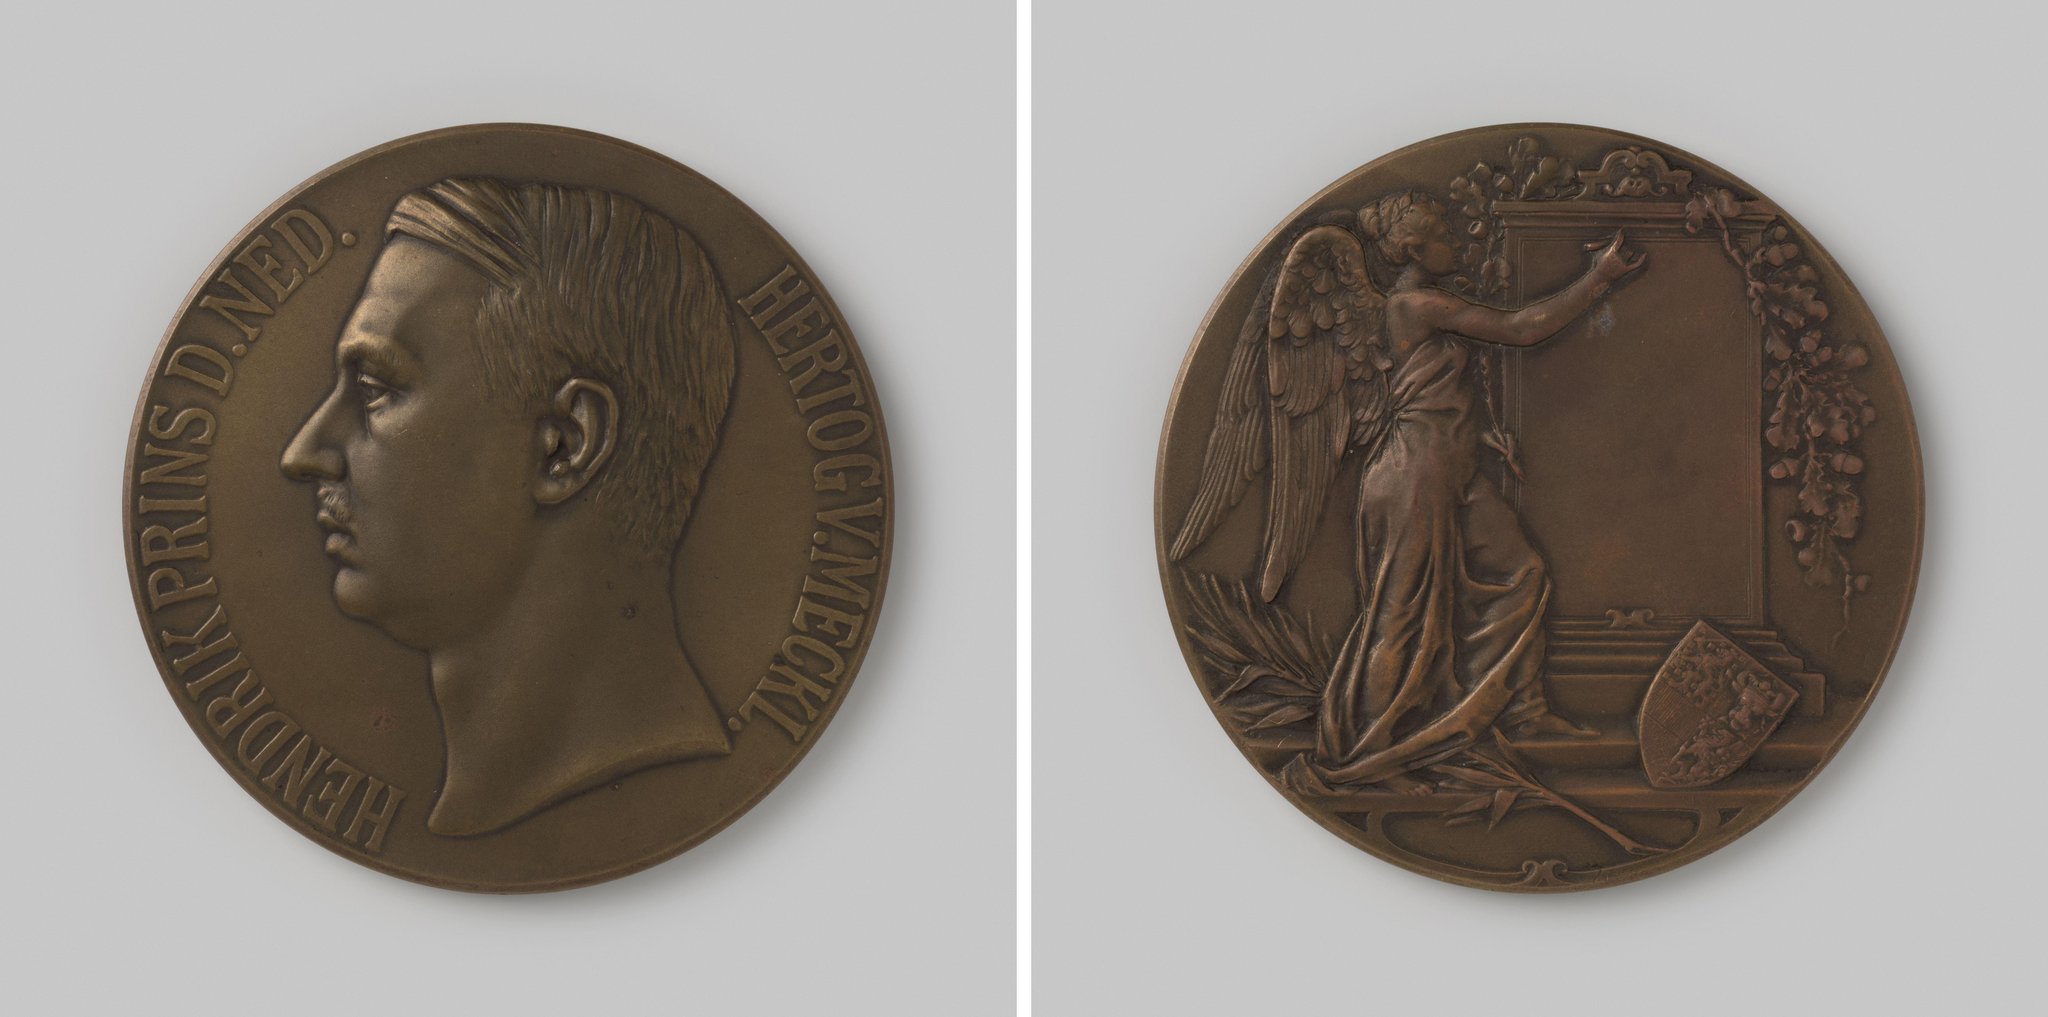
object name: medal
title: Prijspenning van Prins Hendrik der Nederlanden 1902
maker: wilhelm achtenhagen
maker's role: medailleur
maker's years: 1866-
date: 1902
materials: bronze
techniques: striking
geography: utrecht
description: Bronzen penning, op de voorzijde het portret van Prins Hendrik naar links met omschrift, op de keerzijde een gevleugelde vrouw schrijvend op een rechtopstaande gedenksteen omhangen met eikenloof, op de grond een palmtak en het wapenschild van Prins Hendrik.